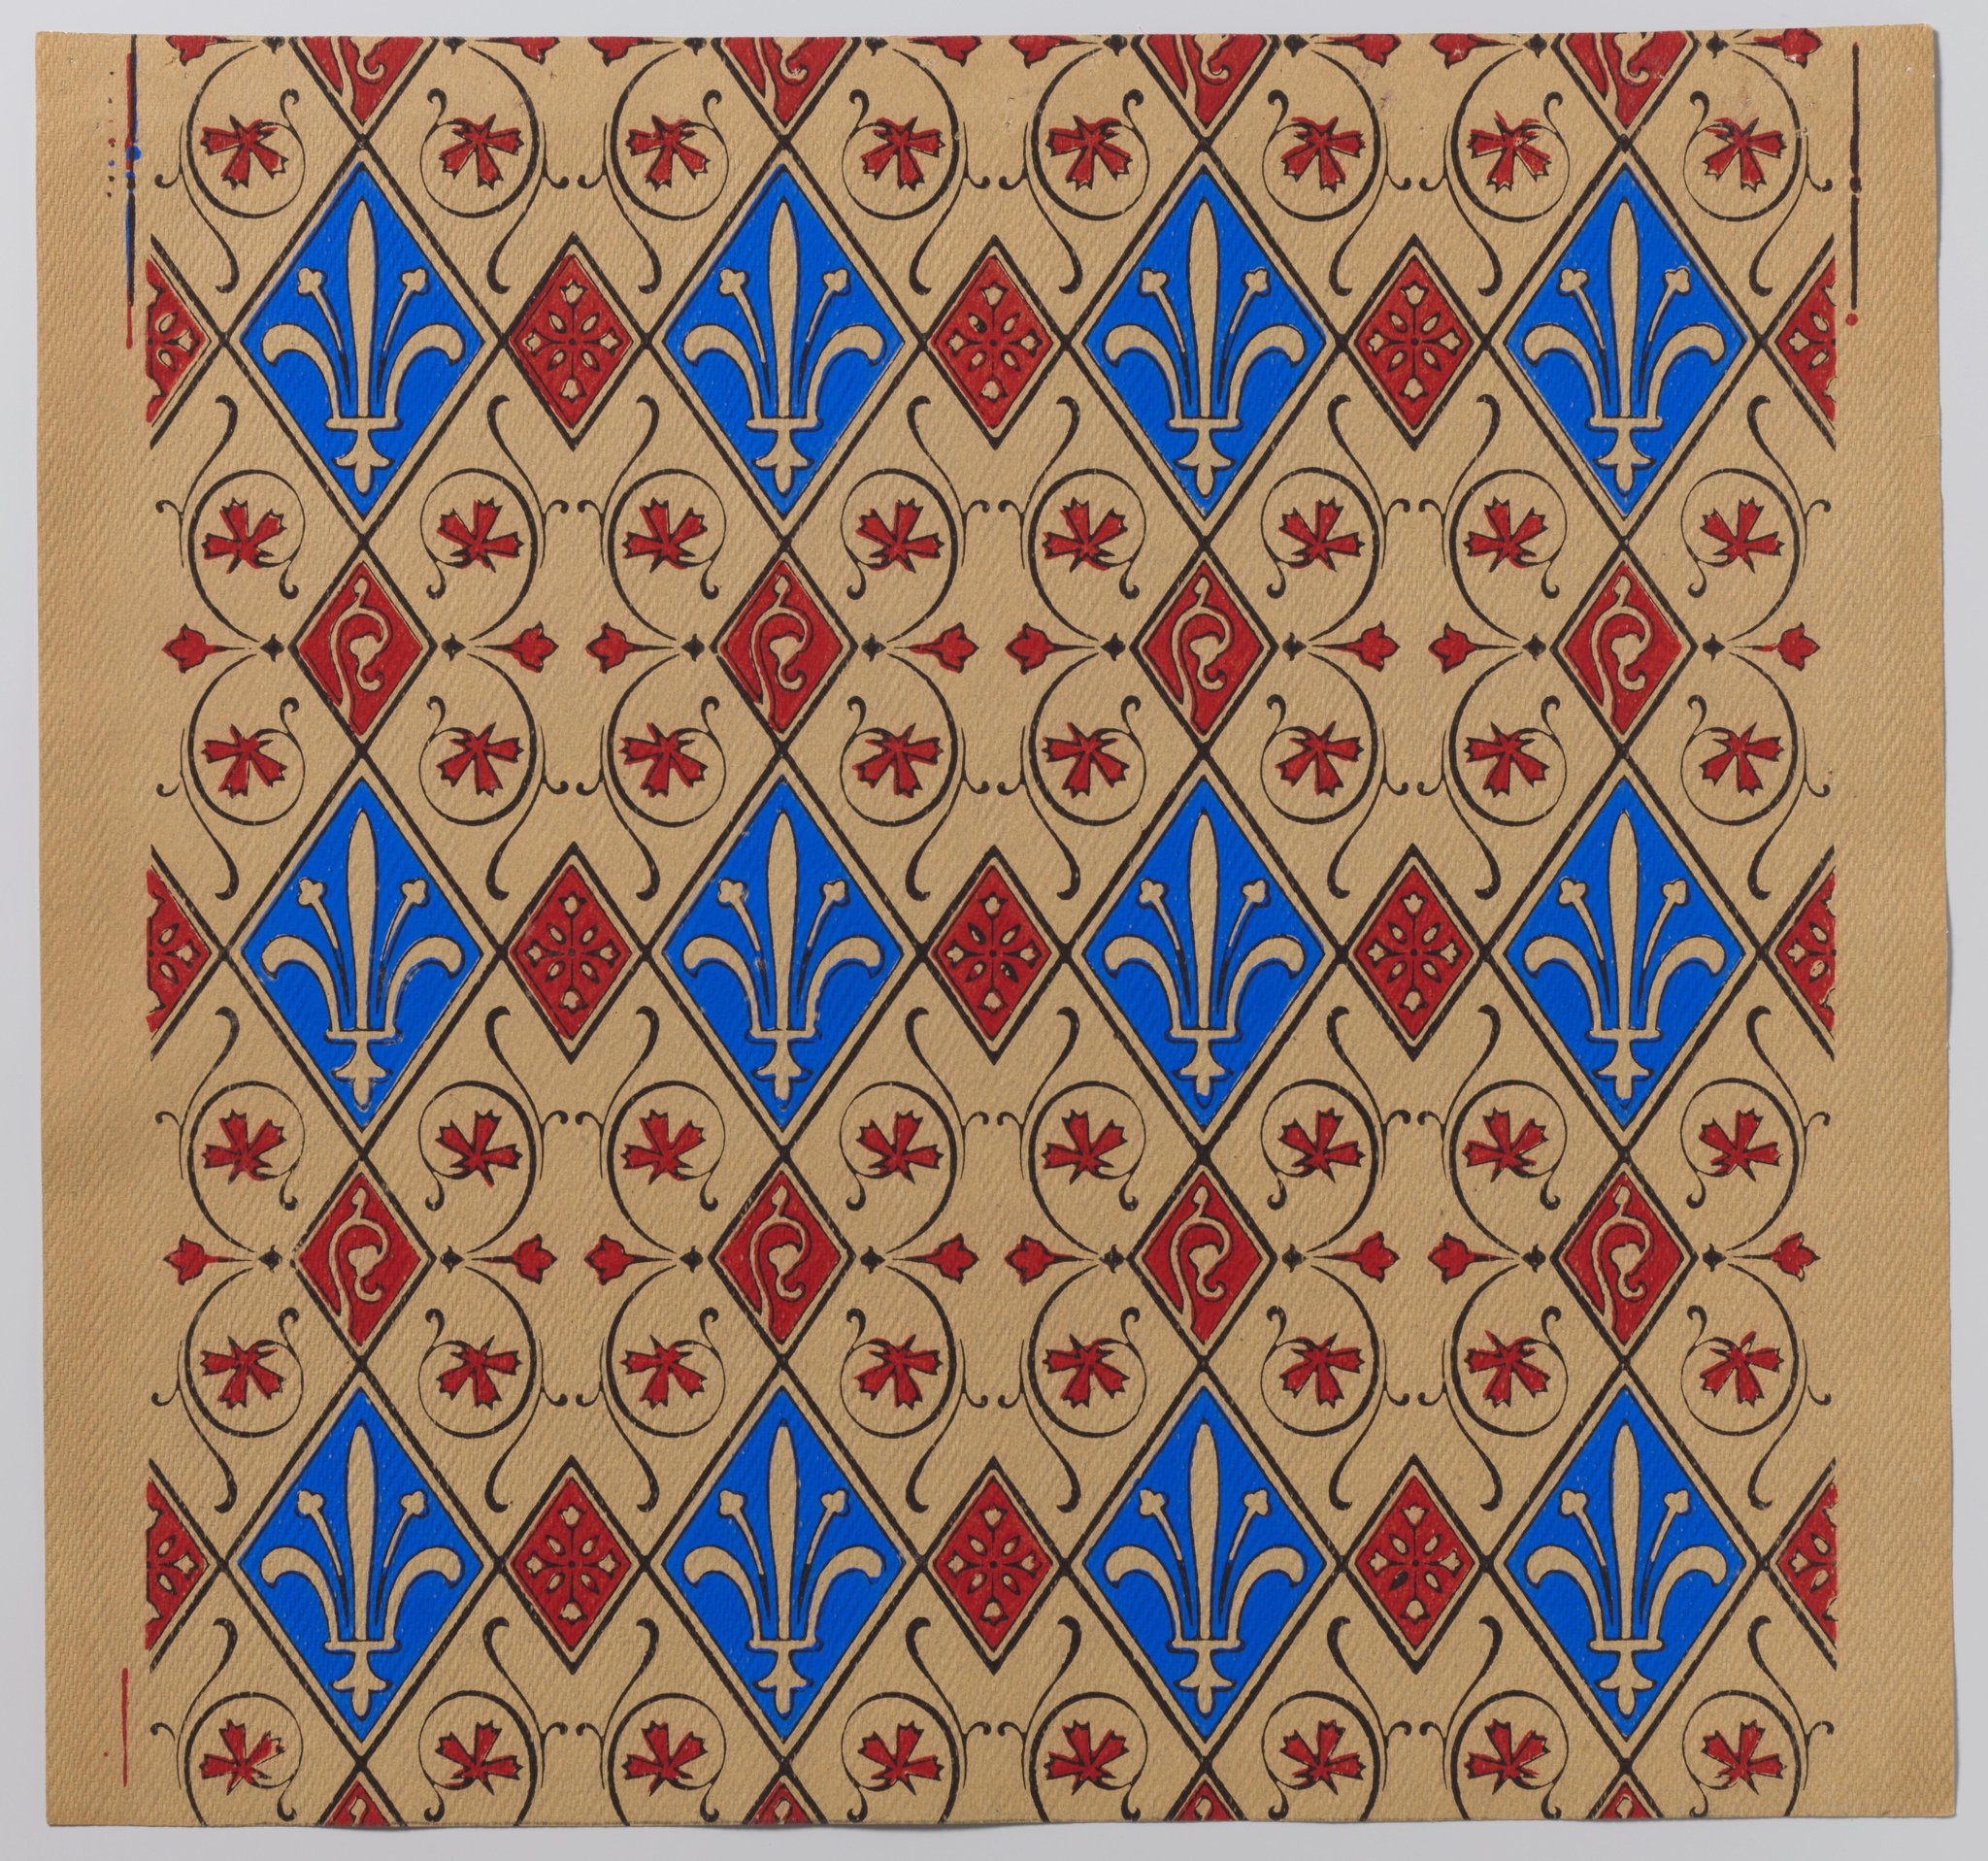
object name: wallpaper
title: Papierbehangsel met ruitpatroon met Franse lelies en bloemetjes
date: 1880-1890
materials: paper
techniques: printing block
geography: france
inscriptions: : ‘in potlood: 9510’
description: Papierbehangsel met ruitpatroon waarbinnen Franse lelies en bloemetjes in rood, zwart en blauw. Blokdruk met een doorlopend patroon, afgewerkt met een cilinderdruk met een gaufrage in een visgraatpatroon, bij wijze van textielimitatie.